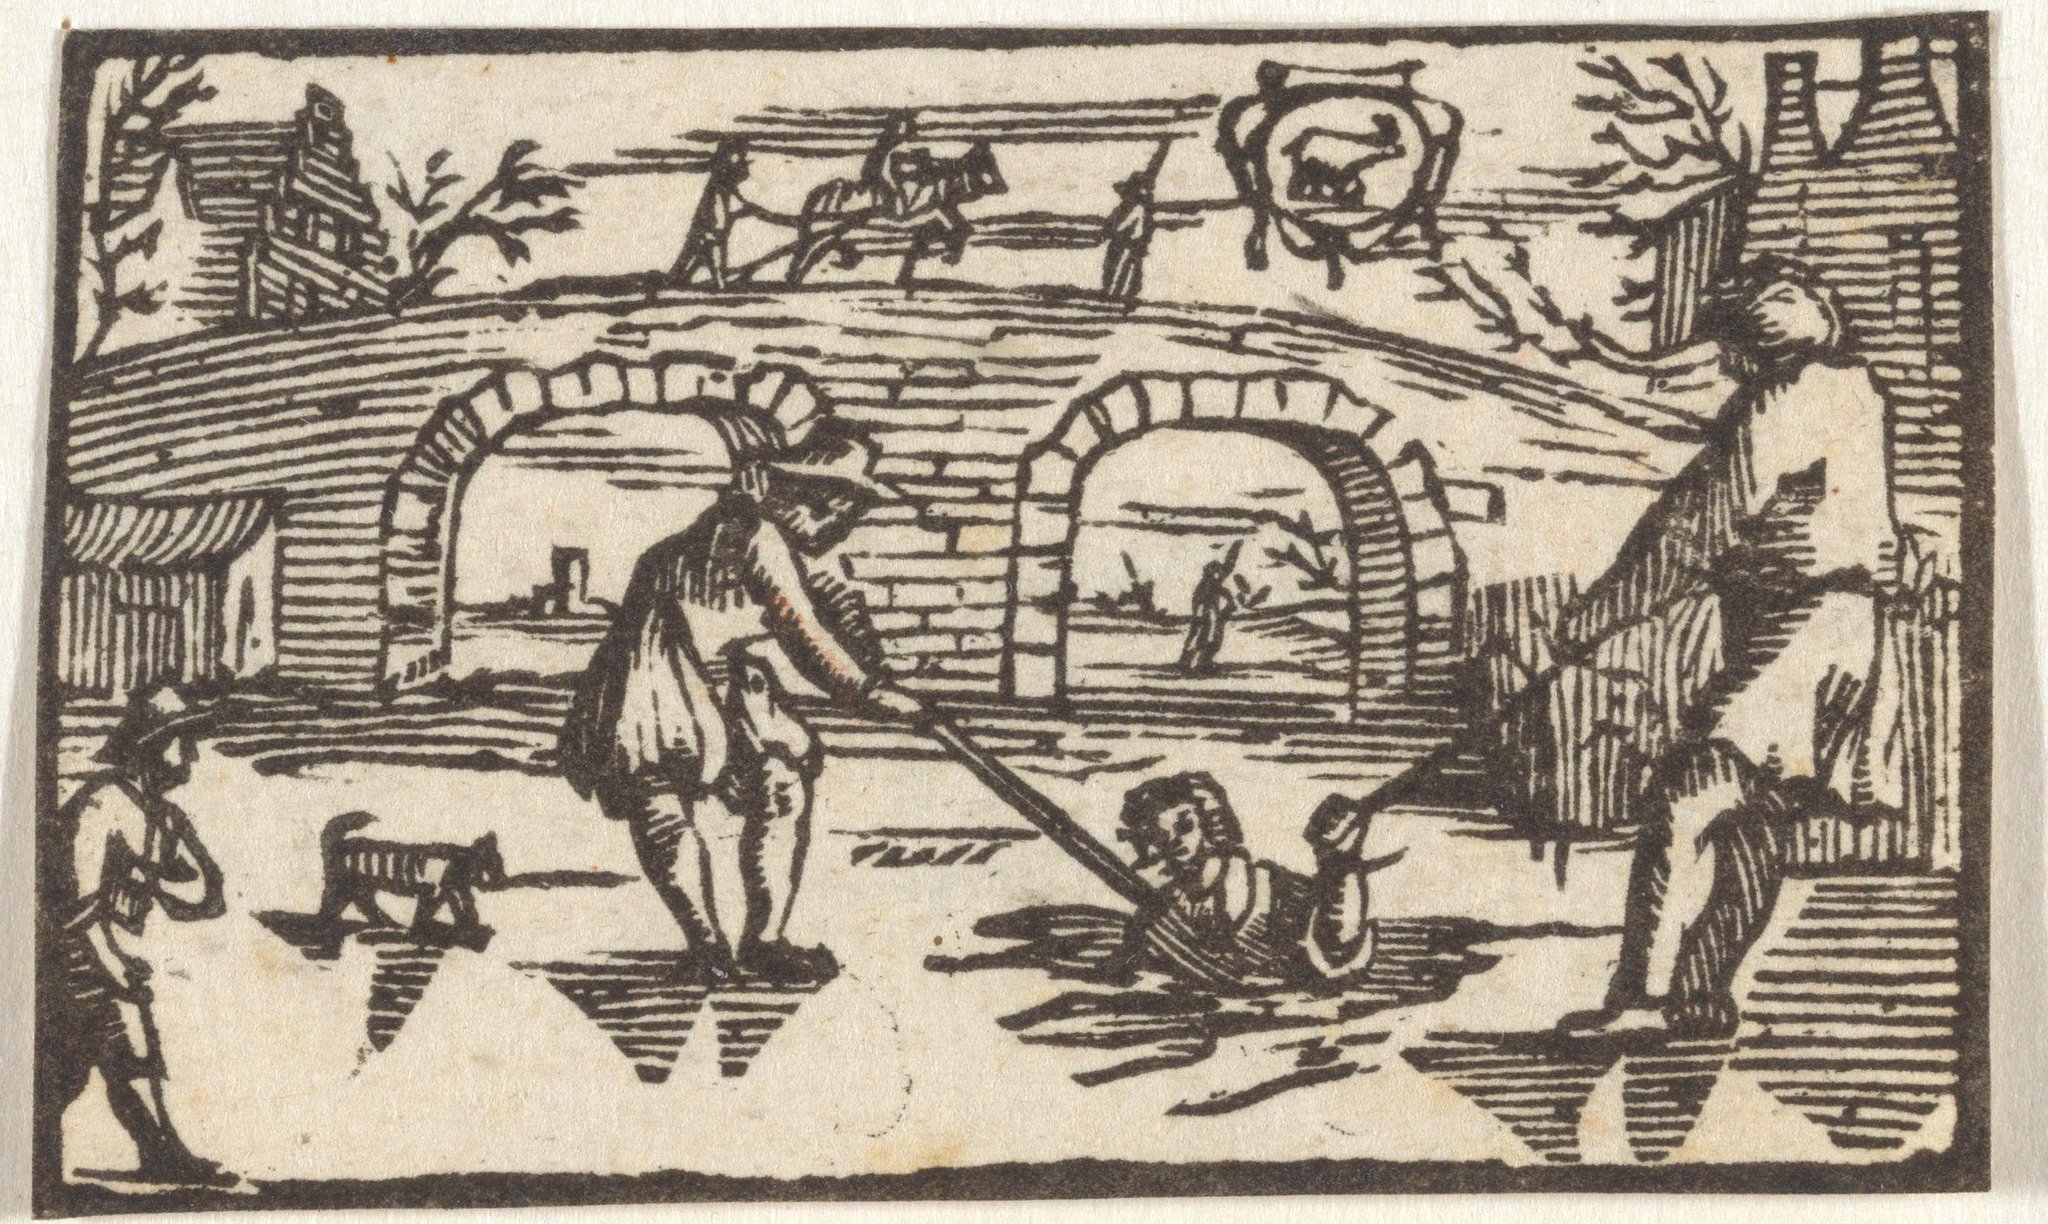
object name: print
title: Maanden van het jaar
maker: Anonymous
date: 1600-1699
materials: paper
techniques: woodcut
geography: netherlands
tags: december and its 'labours' (+ with capricorn (december)), bridge in city across river, canal, etc., accident on snow or ice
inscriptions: collector's mark: Lugt 2228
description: Twee mannen een figuur reddend die door het ijs is gezakt. Op de achtergrond een brug. Midden boven een steenbok.